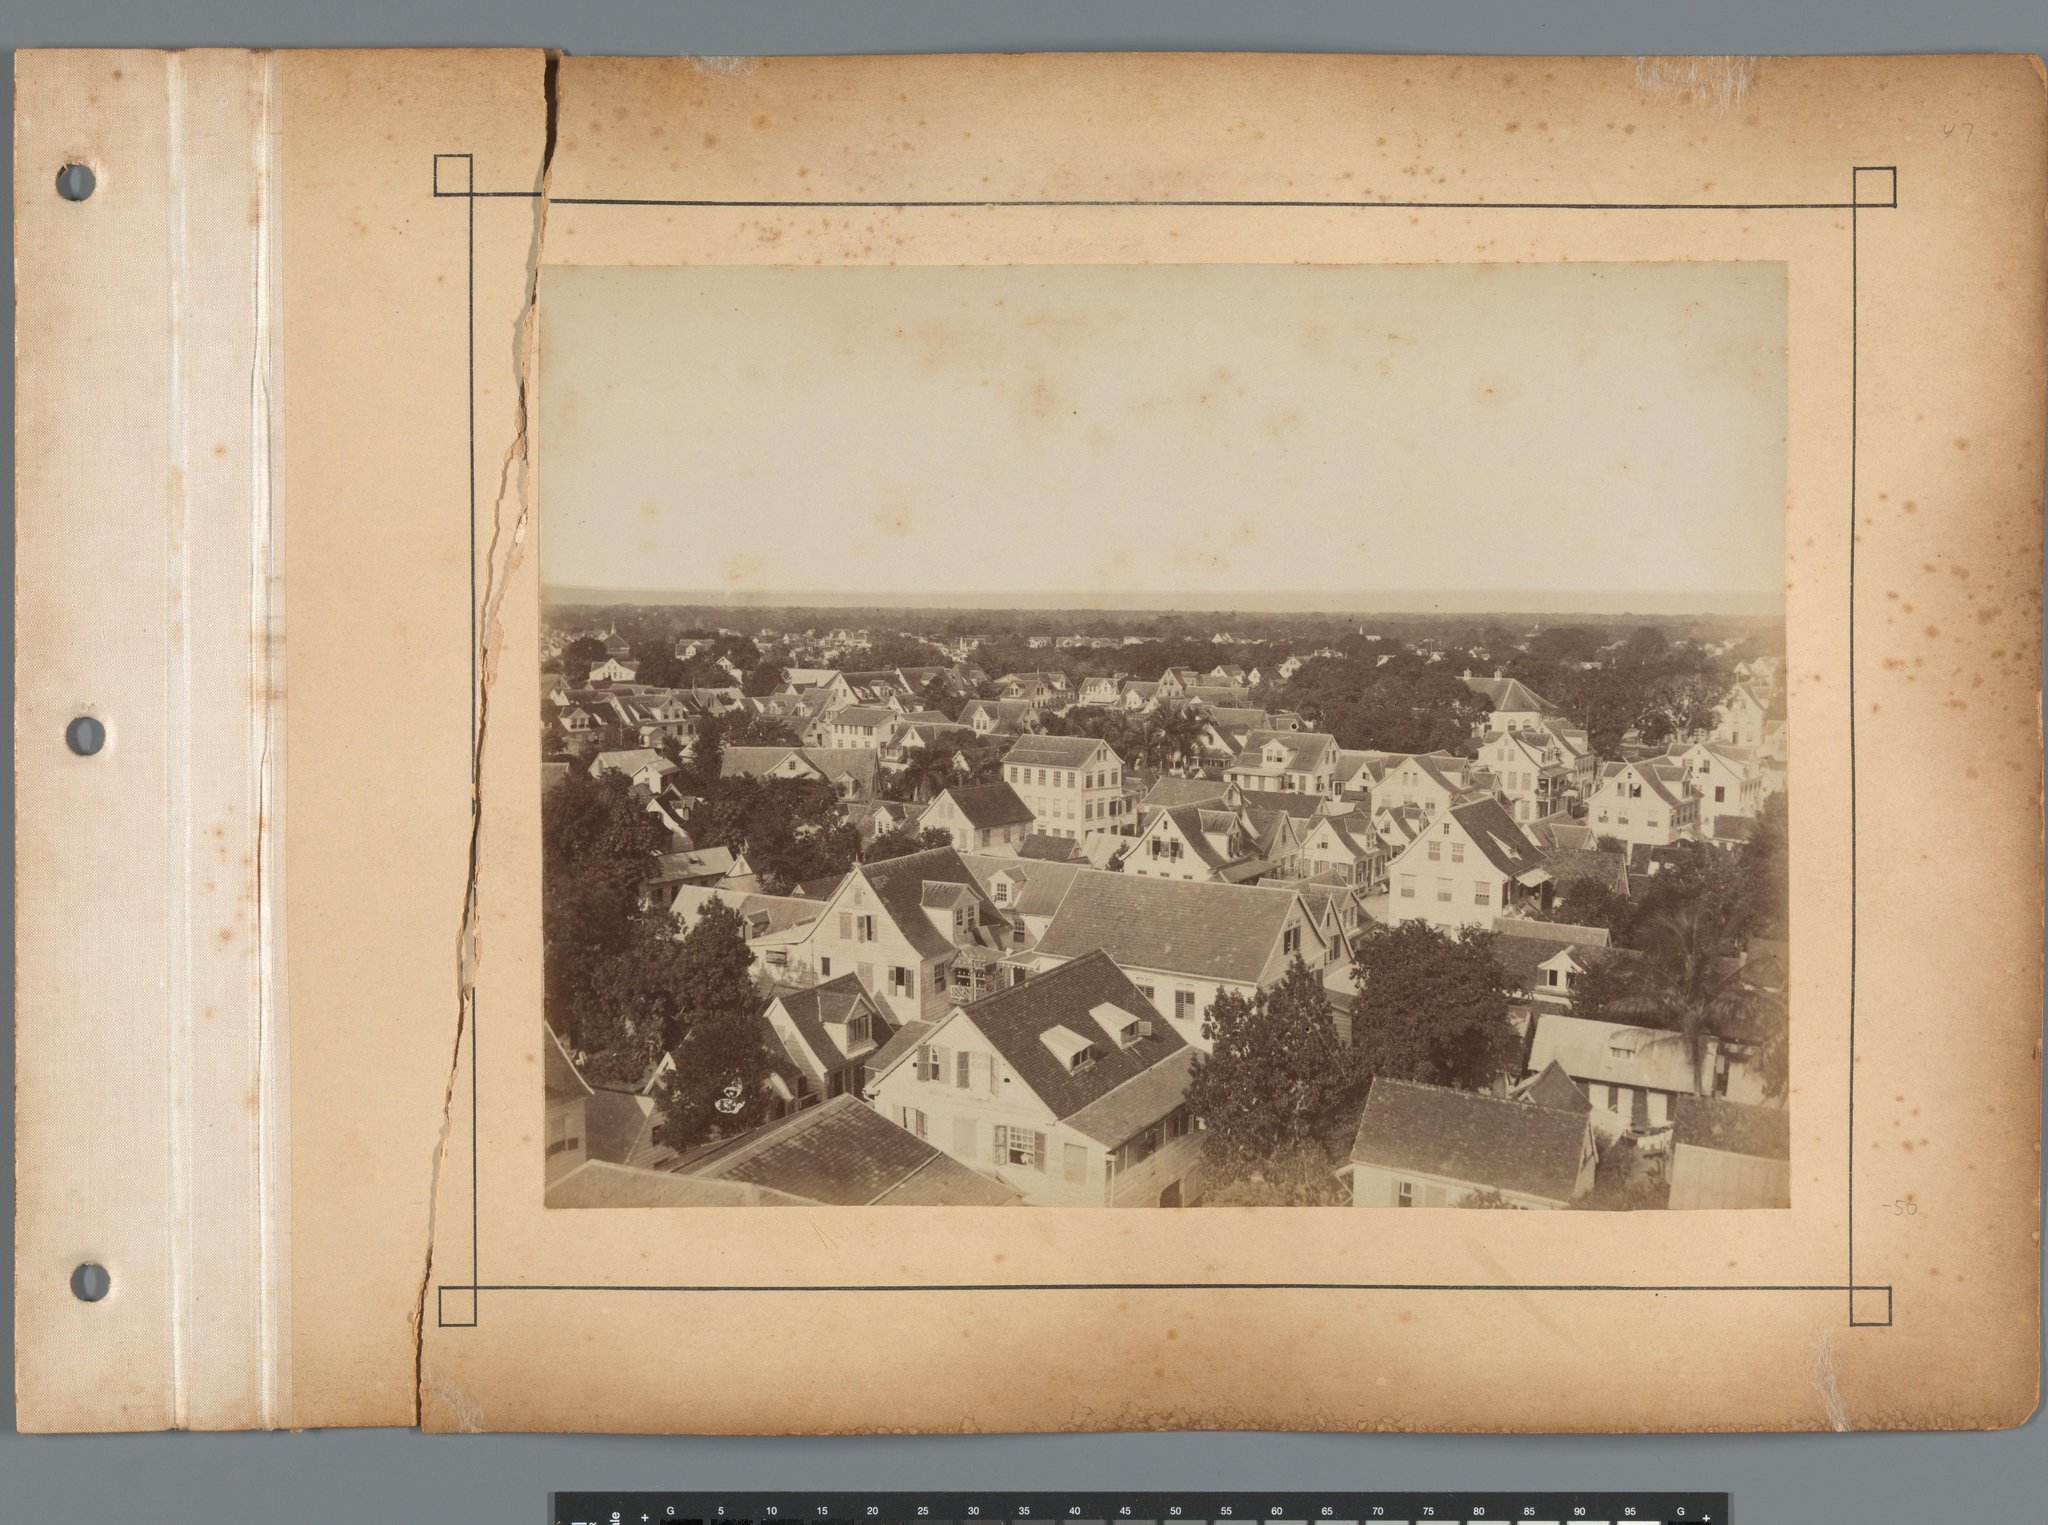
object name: photograph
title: Vogelvluchtperspectief Paramaribo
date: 1898-1902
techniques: albumen print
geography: suriname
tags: city-view in general; 'veduta', suriname